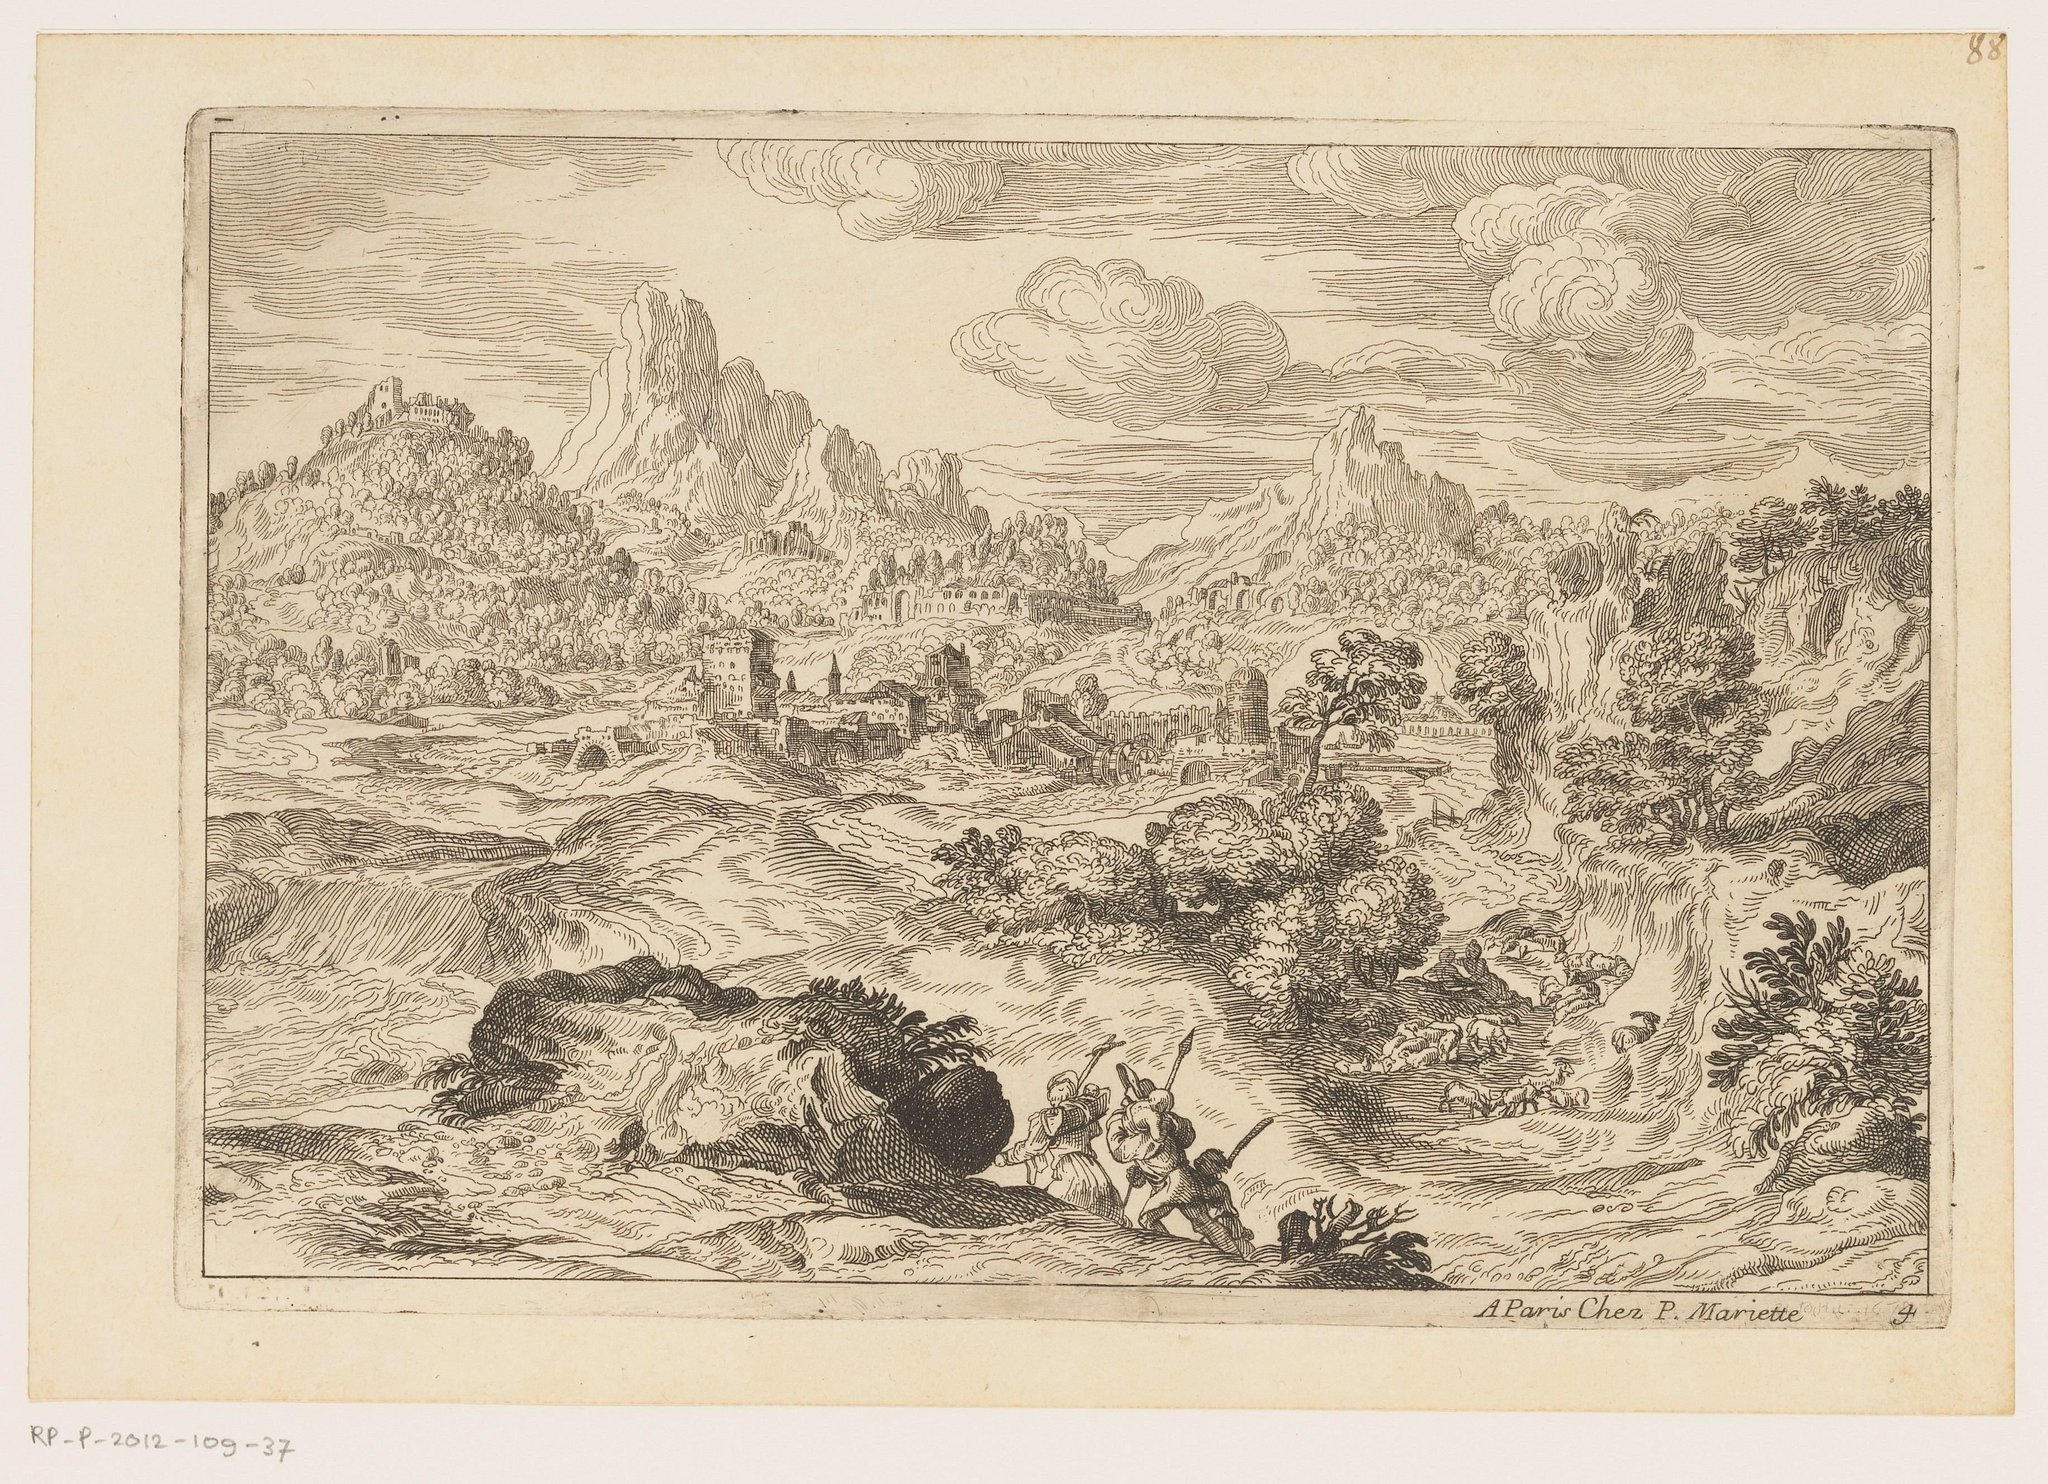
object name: print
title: Landschap met reizigers en herders met een kudde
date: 1663-1726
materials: paper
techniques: etching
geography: paris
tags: (traveller) resting in the open air, herd, flock, mountains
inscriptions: collector's mark: Lugt 2228, collector's mark: Lugt 3474, collector's mark: Lugt 3473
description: Maakt deel uit van vierentwintigdelige serie met landschappen naar Titiaan en Campagnola.